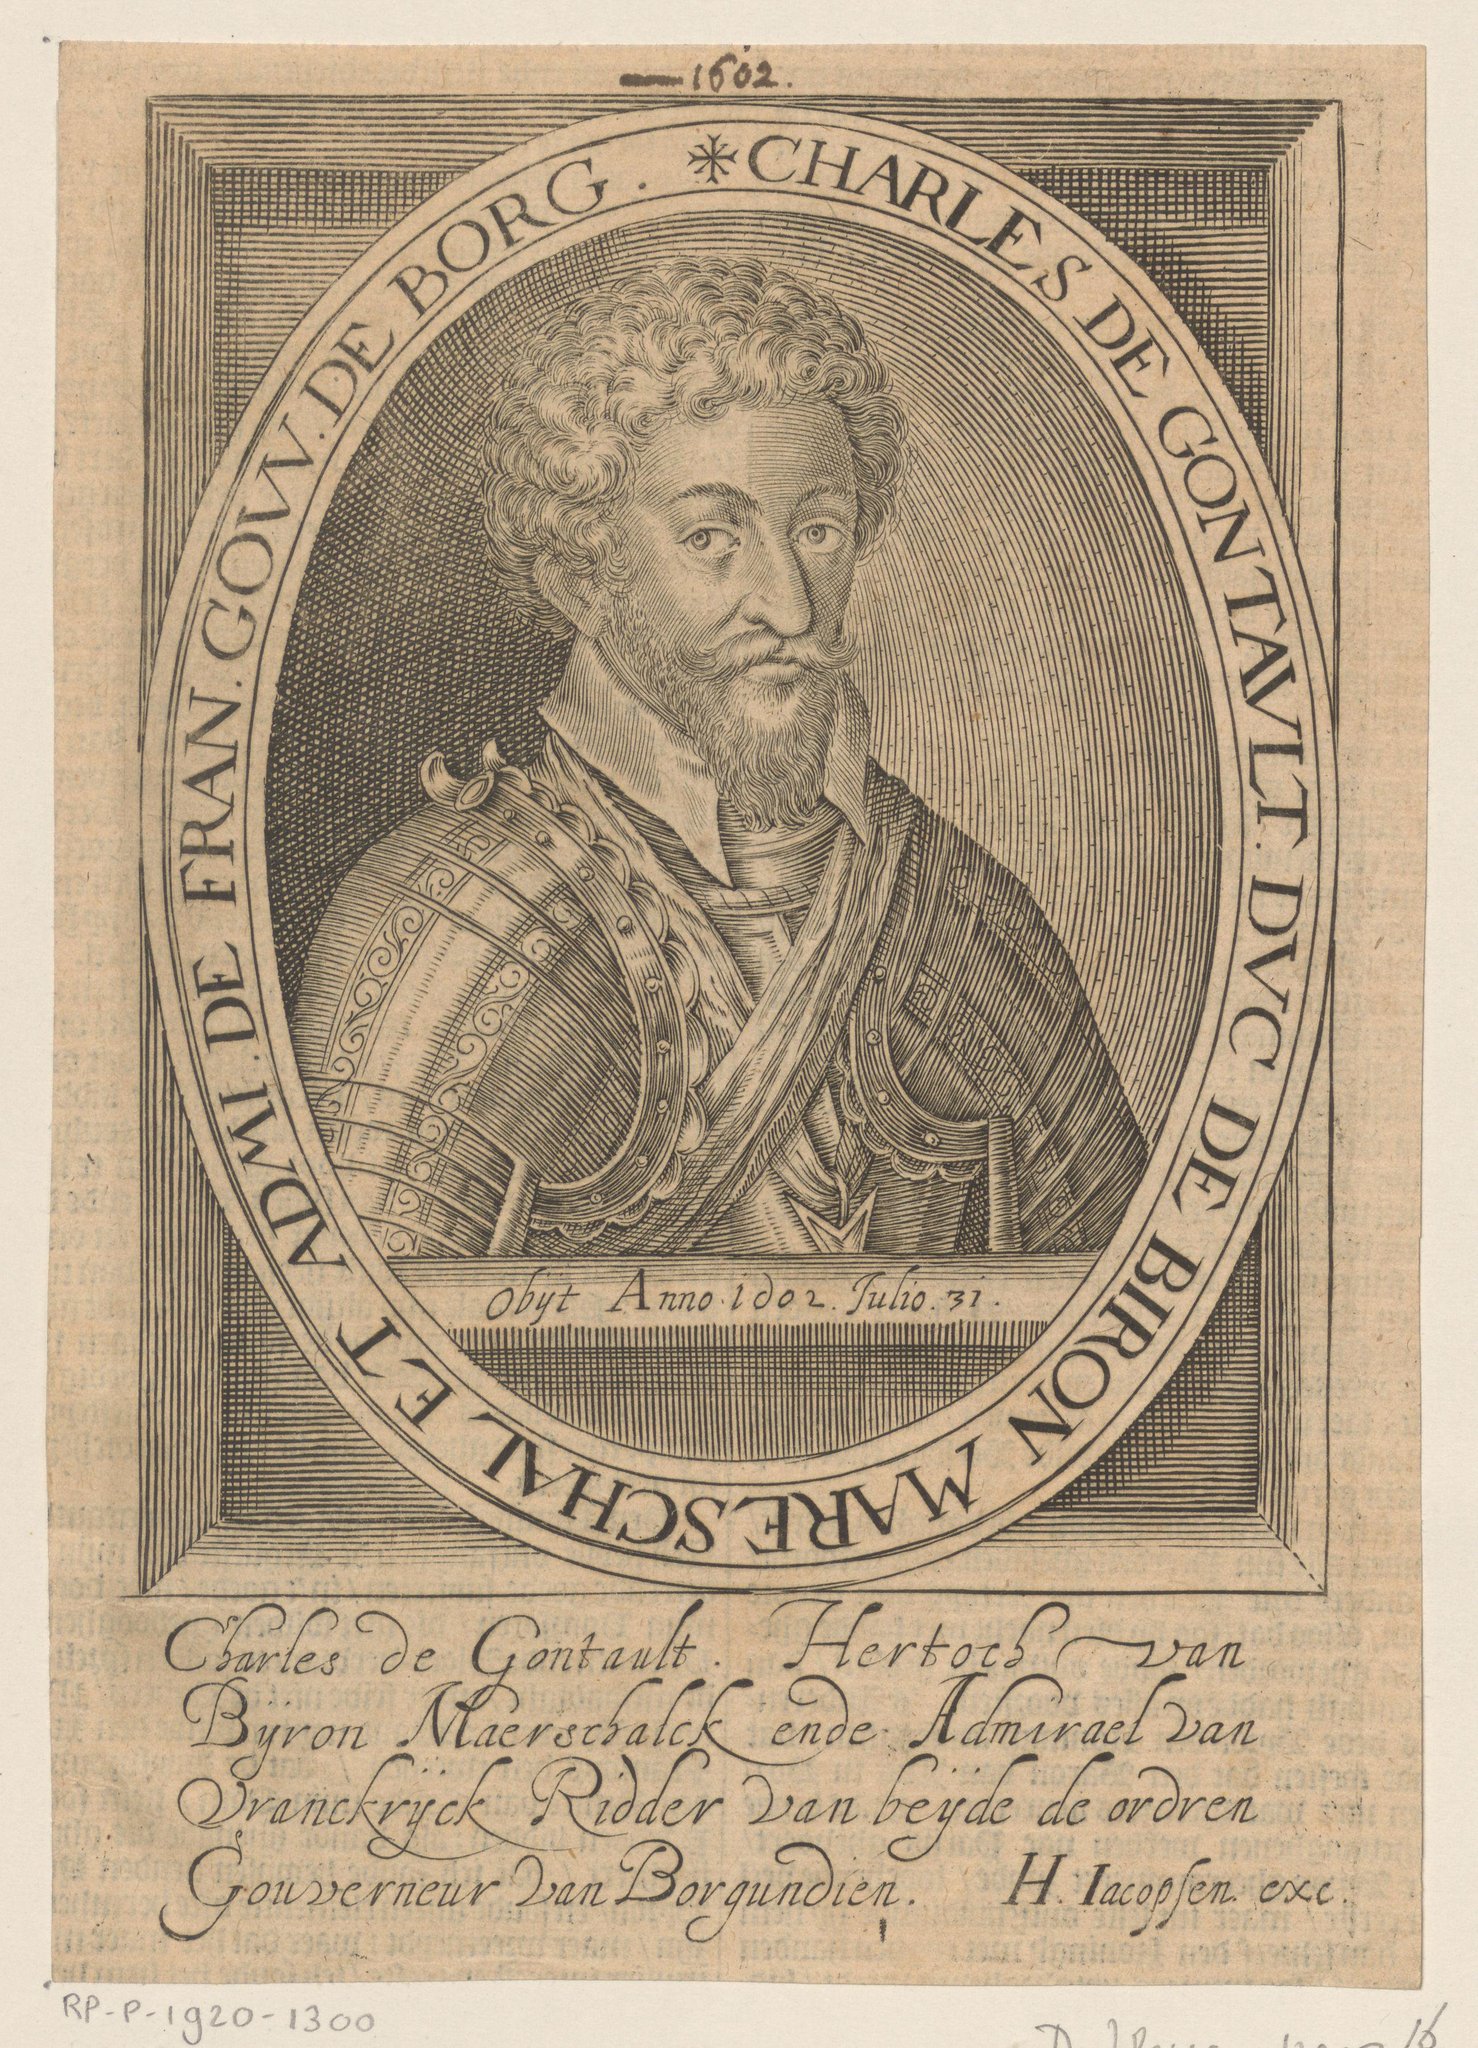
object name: print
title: Portret van Charles de Gontaut, heer van Biron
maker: Anonymous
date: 1635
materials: paper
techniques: engraving, letterpress printing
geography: the hague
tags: armour, historical persons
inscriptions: collector's mark: Lugt 2228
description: Prent uit: Meteren, Emanuel van. Historie der Neder-landscher ende haerder na-buren oorlogen ende geschiedenissen (...). Den Haag: weduwe en erven Hillebrant Jacobsz. van Wouw, 1635. Prent mogelijk ook in andere edities van dit werk verschenen.